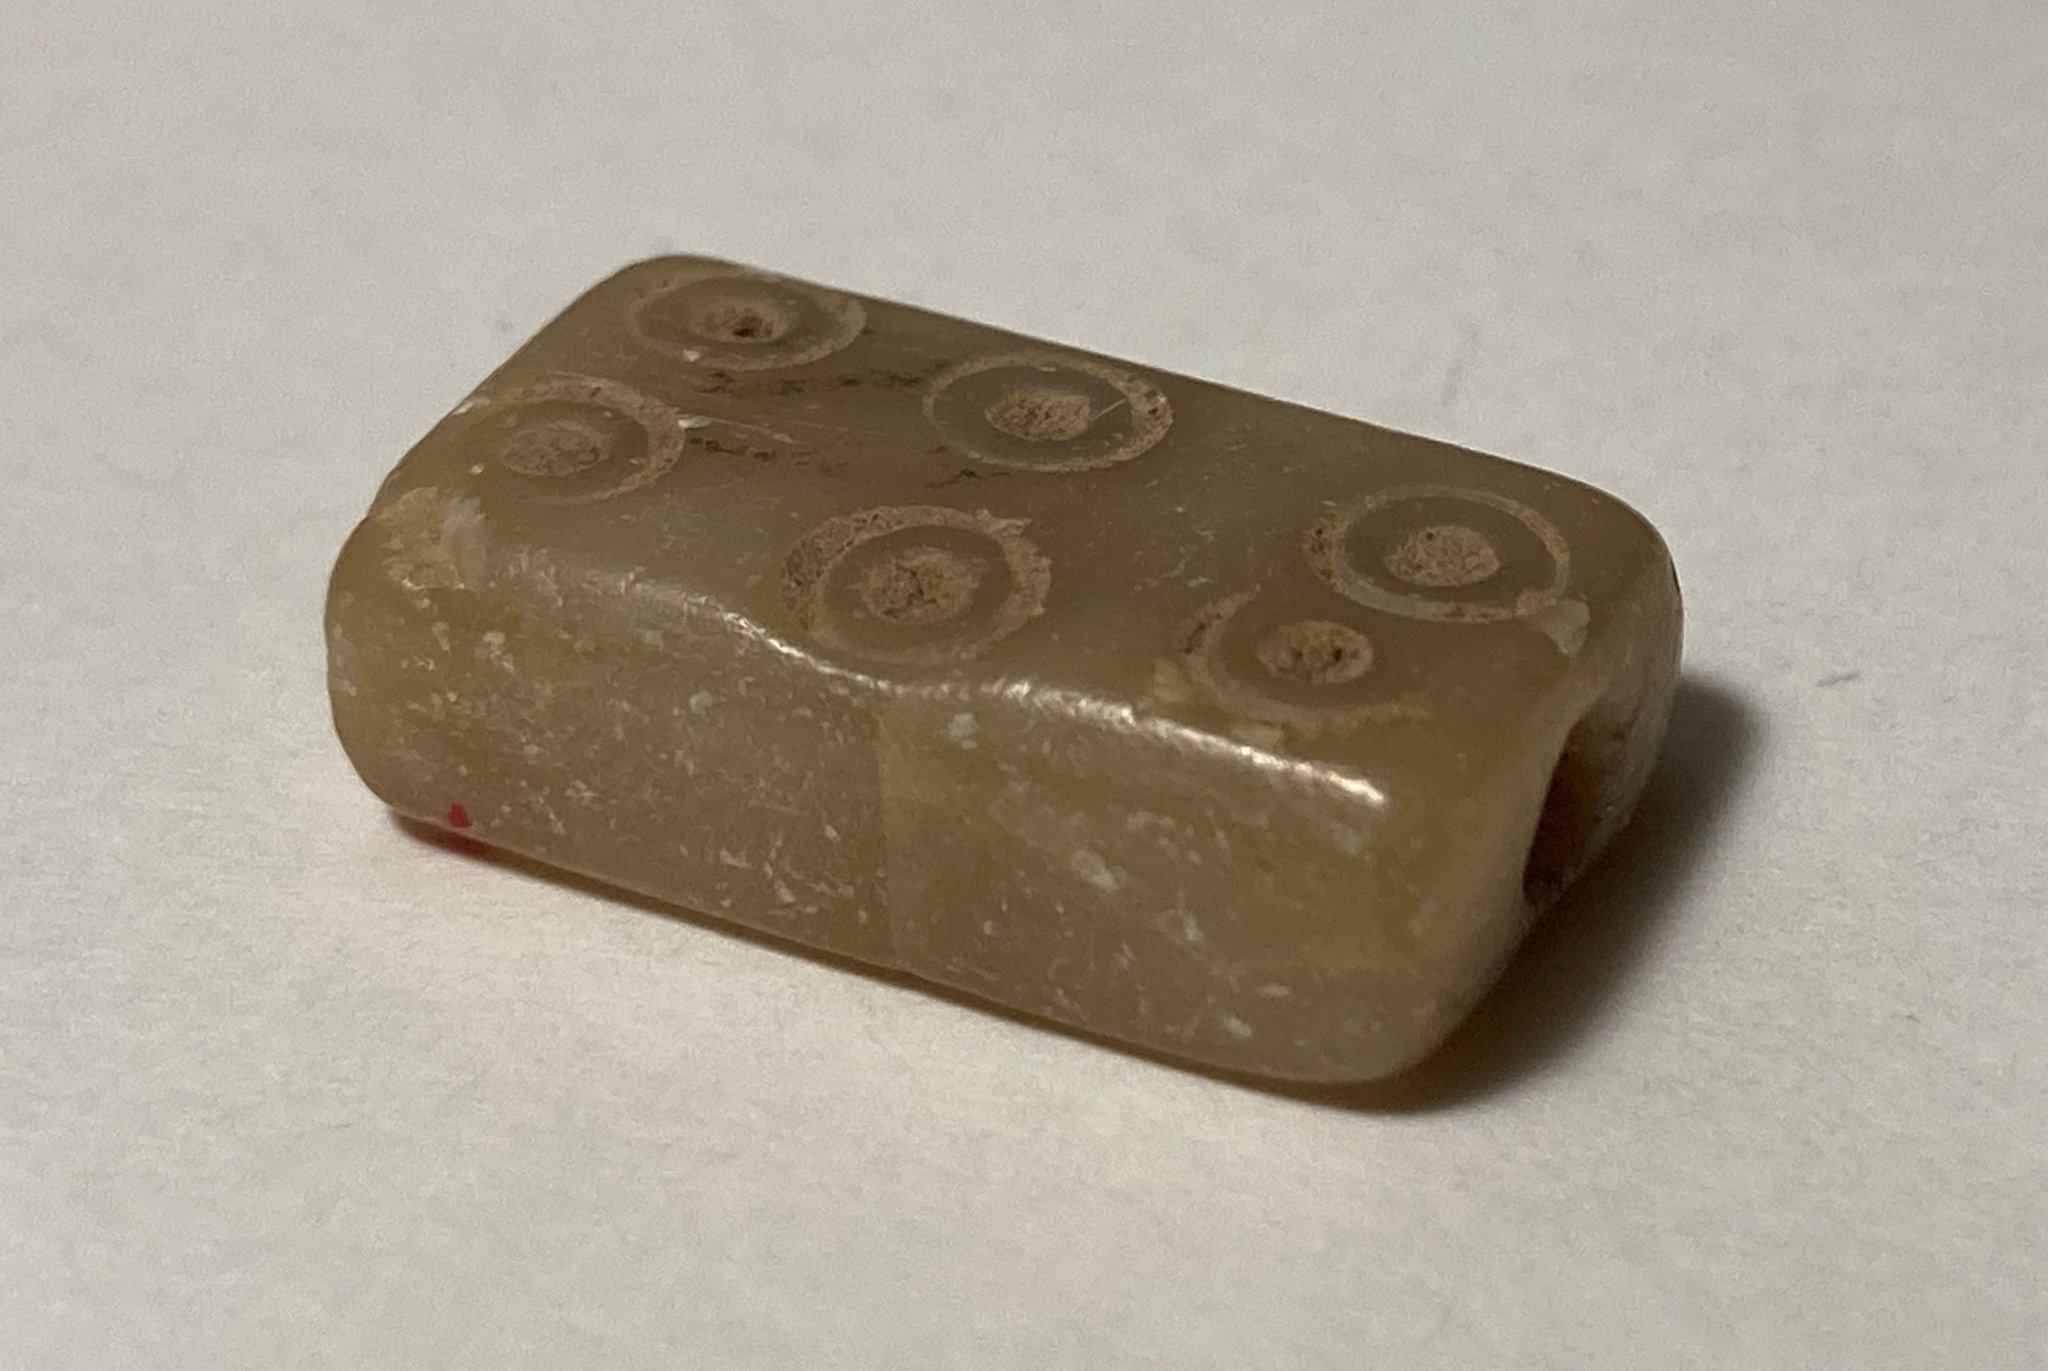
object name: bead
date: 701-1300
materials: stone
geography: iran